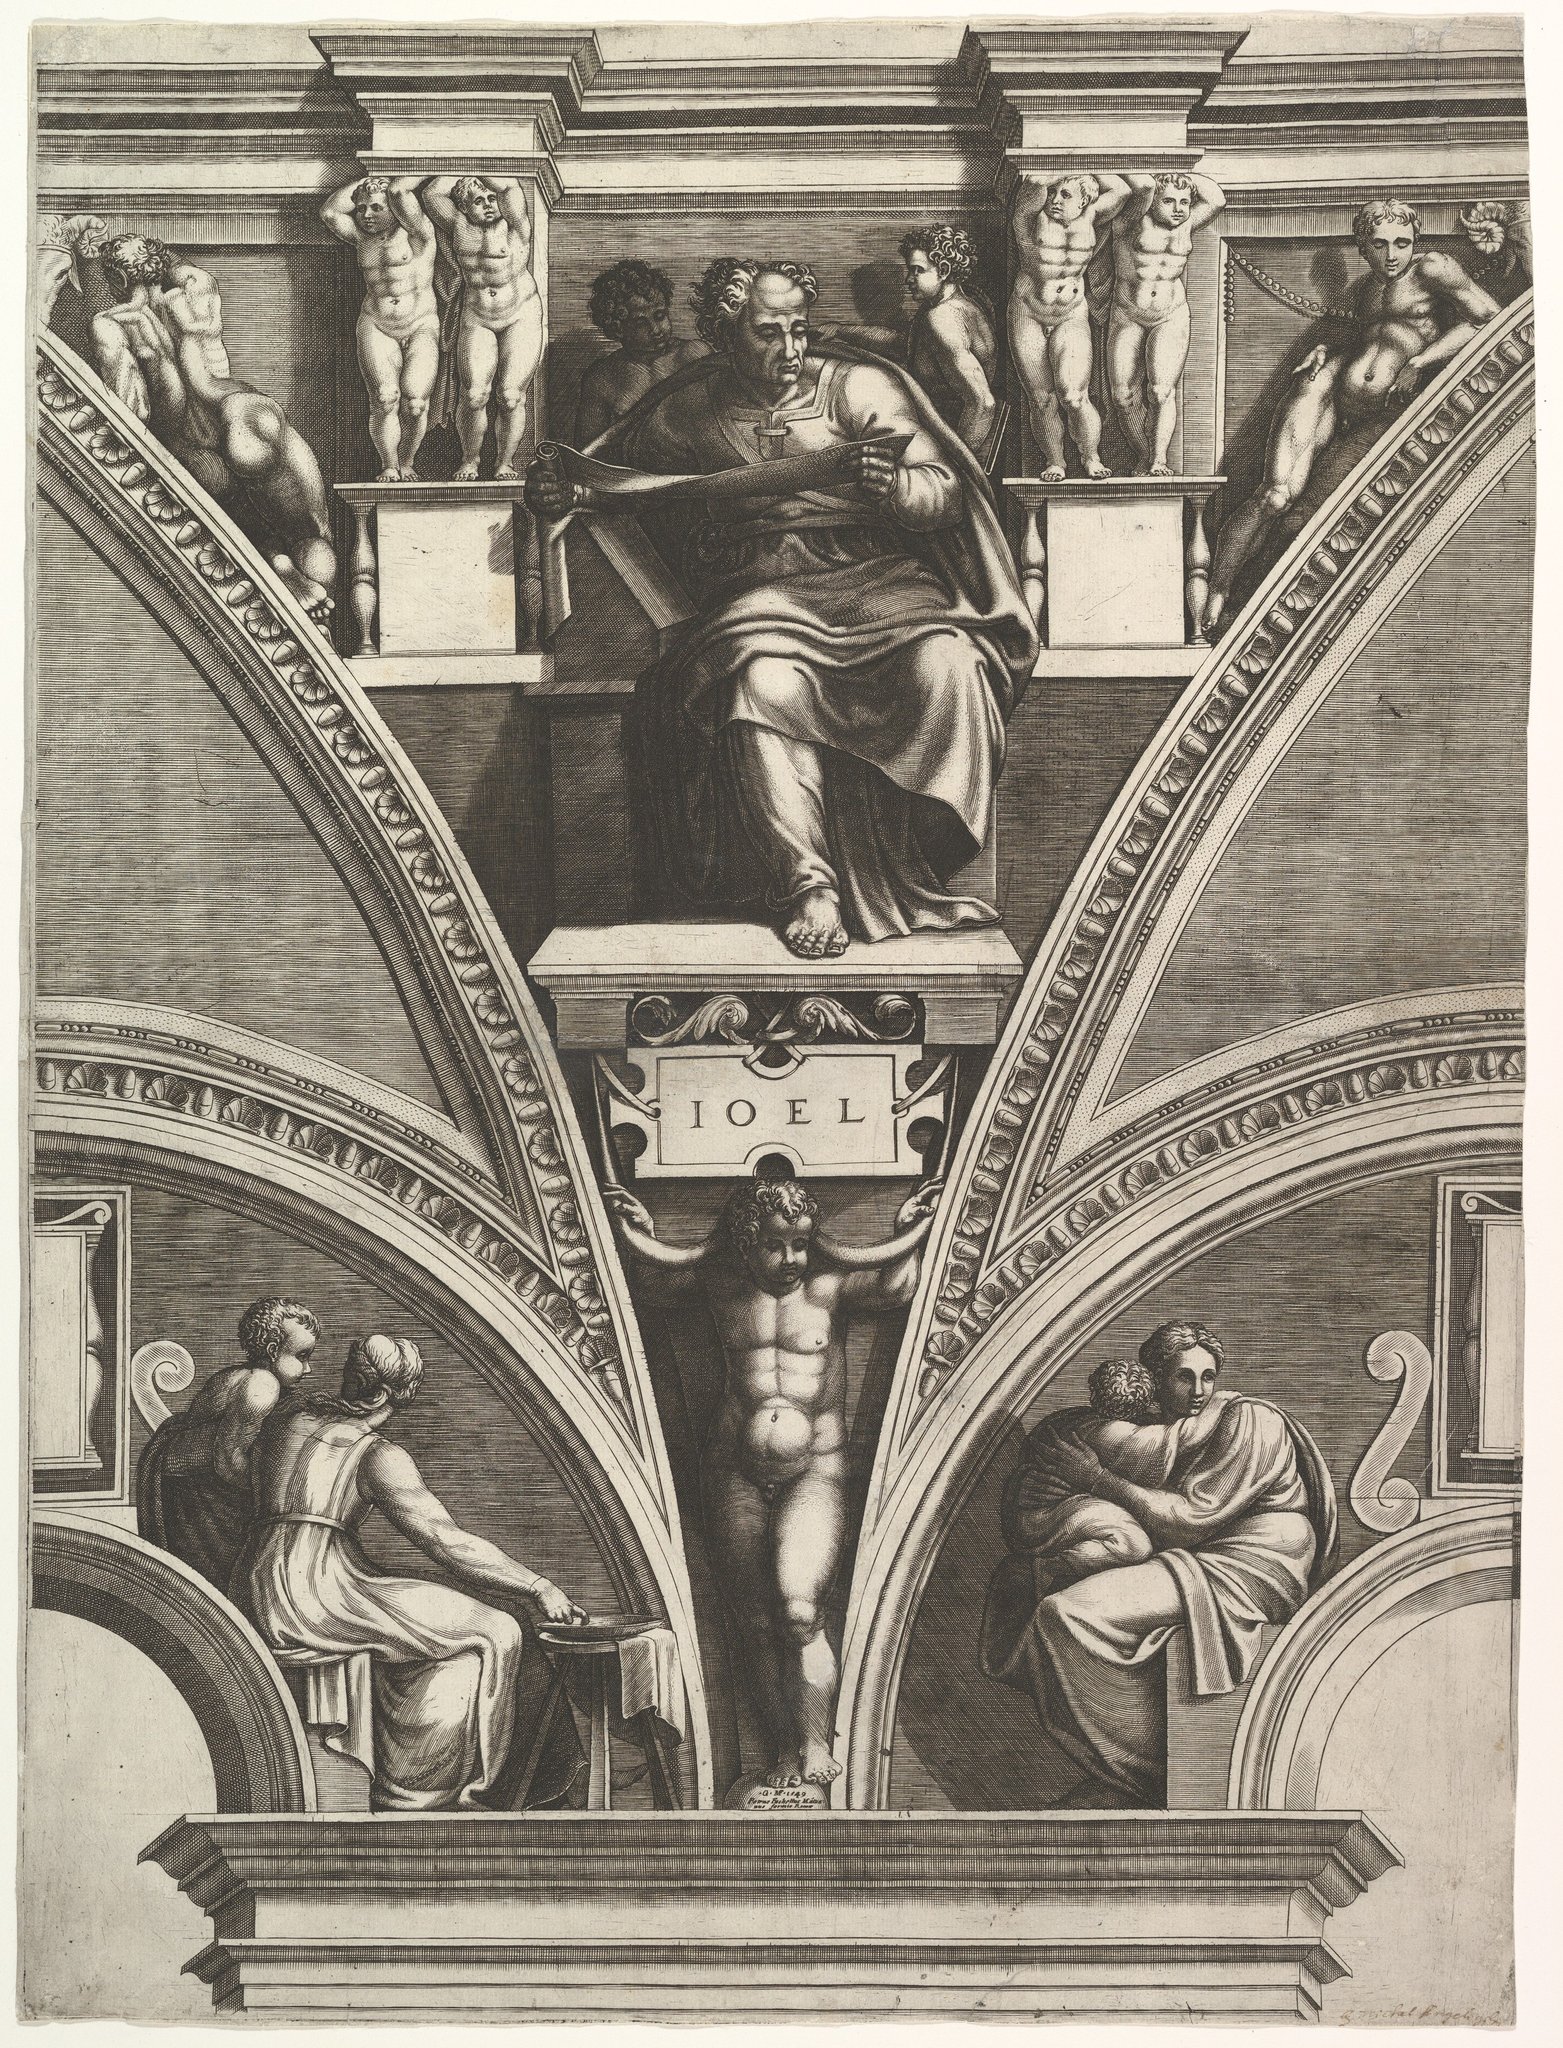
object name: print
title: The Prophet Joel; from the series of Prophets and Sibyls in the Sistine Chapel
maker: giorgio ghisi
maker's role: artist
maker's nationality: italian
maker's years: 1515-1582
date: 1570-1575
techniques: engraving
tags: caryatids,infants,men,male nudes,women